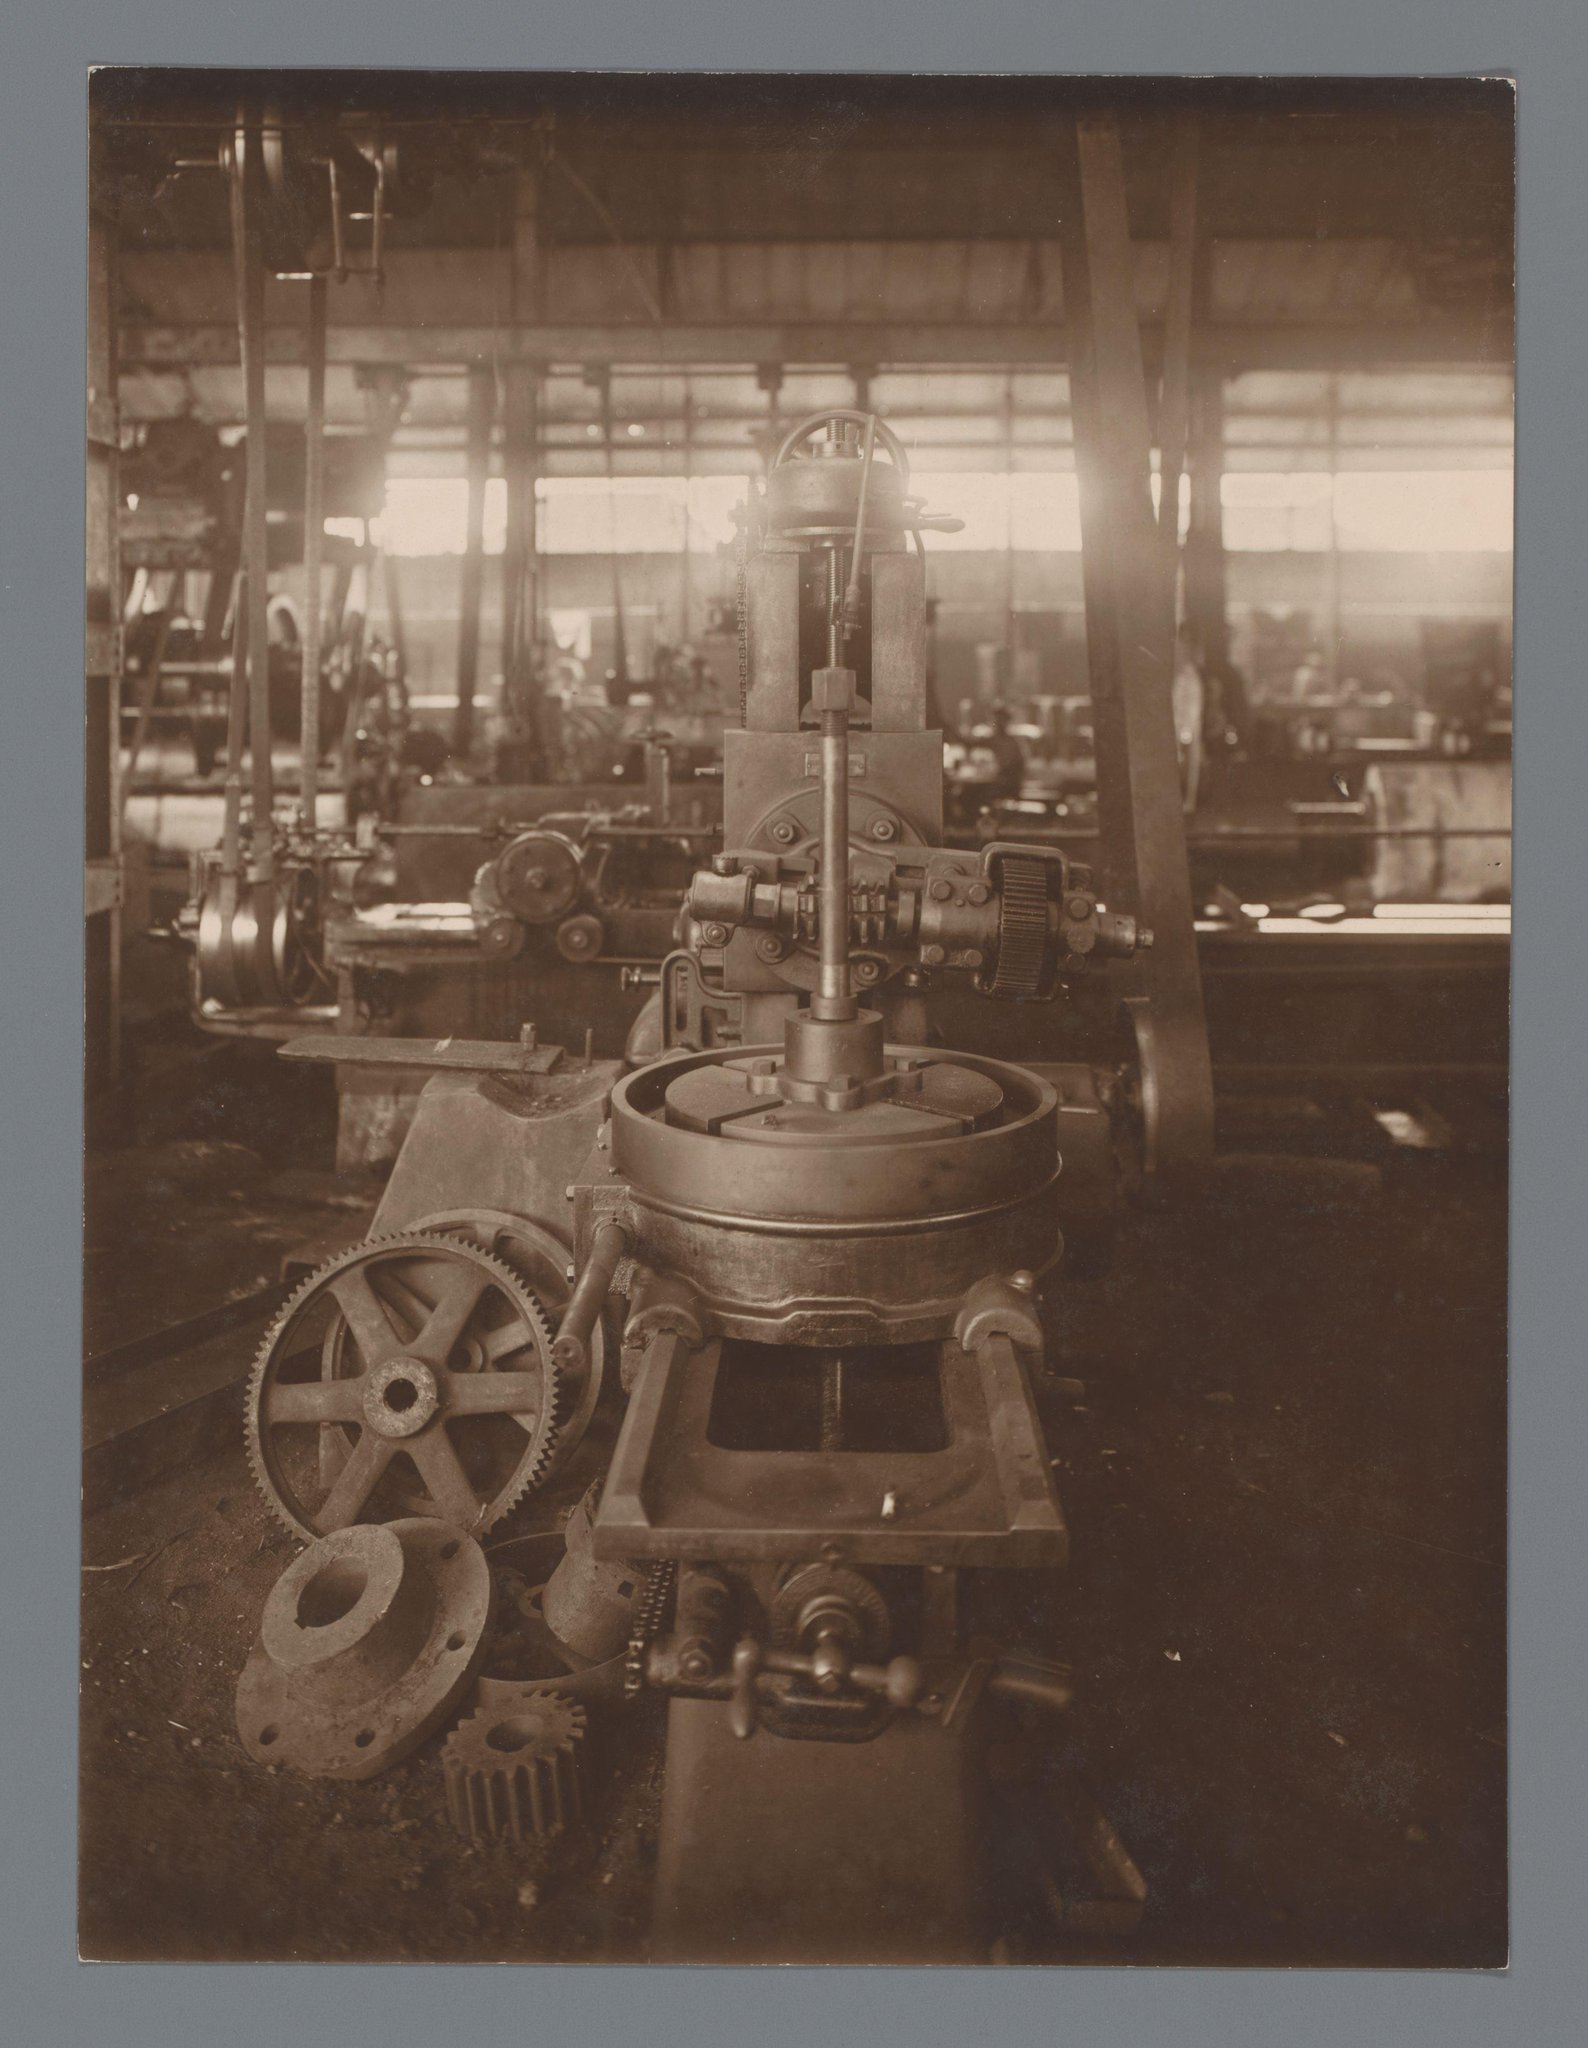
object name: photograph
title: Freesmachine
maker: Anonymous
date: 1919-1921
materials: photographic support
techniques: gelatin silver print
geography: surabaya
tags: colonial system, factory-interior, machine shop, machines; parts of machines; tools and appliances, java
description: De eerste rechte tandwielen freesmachine uit ca. 1916. Onderdeel van de multomap met foto's van machines van de N.V. Machinefabriek Braat te Soerabaja, Soekaboemi en Jogyakarta, uit de periode 1908-1942.